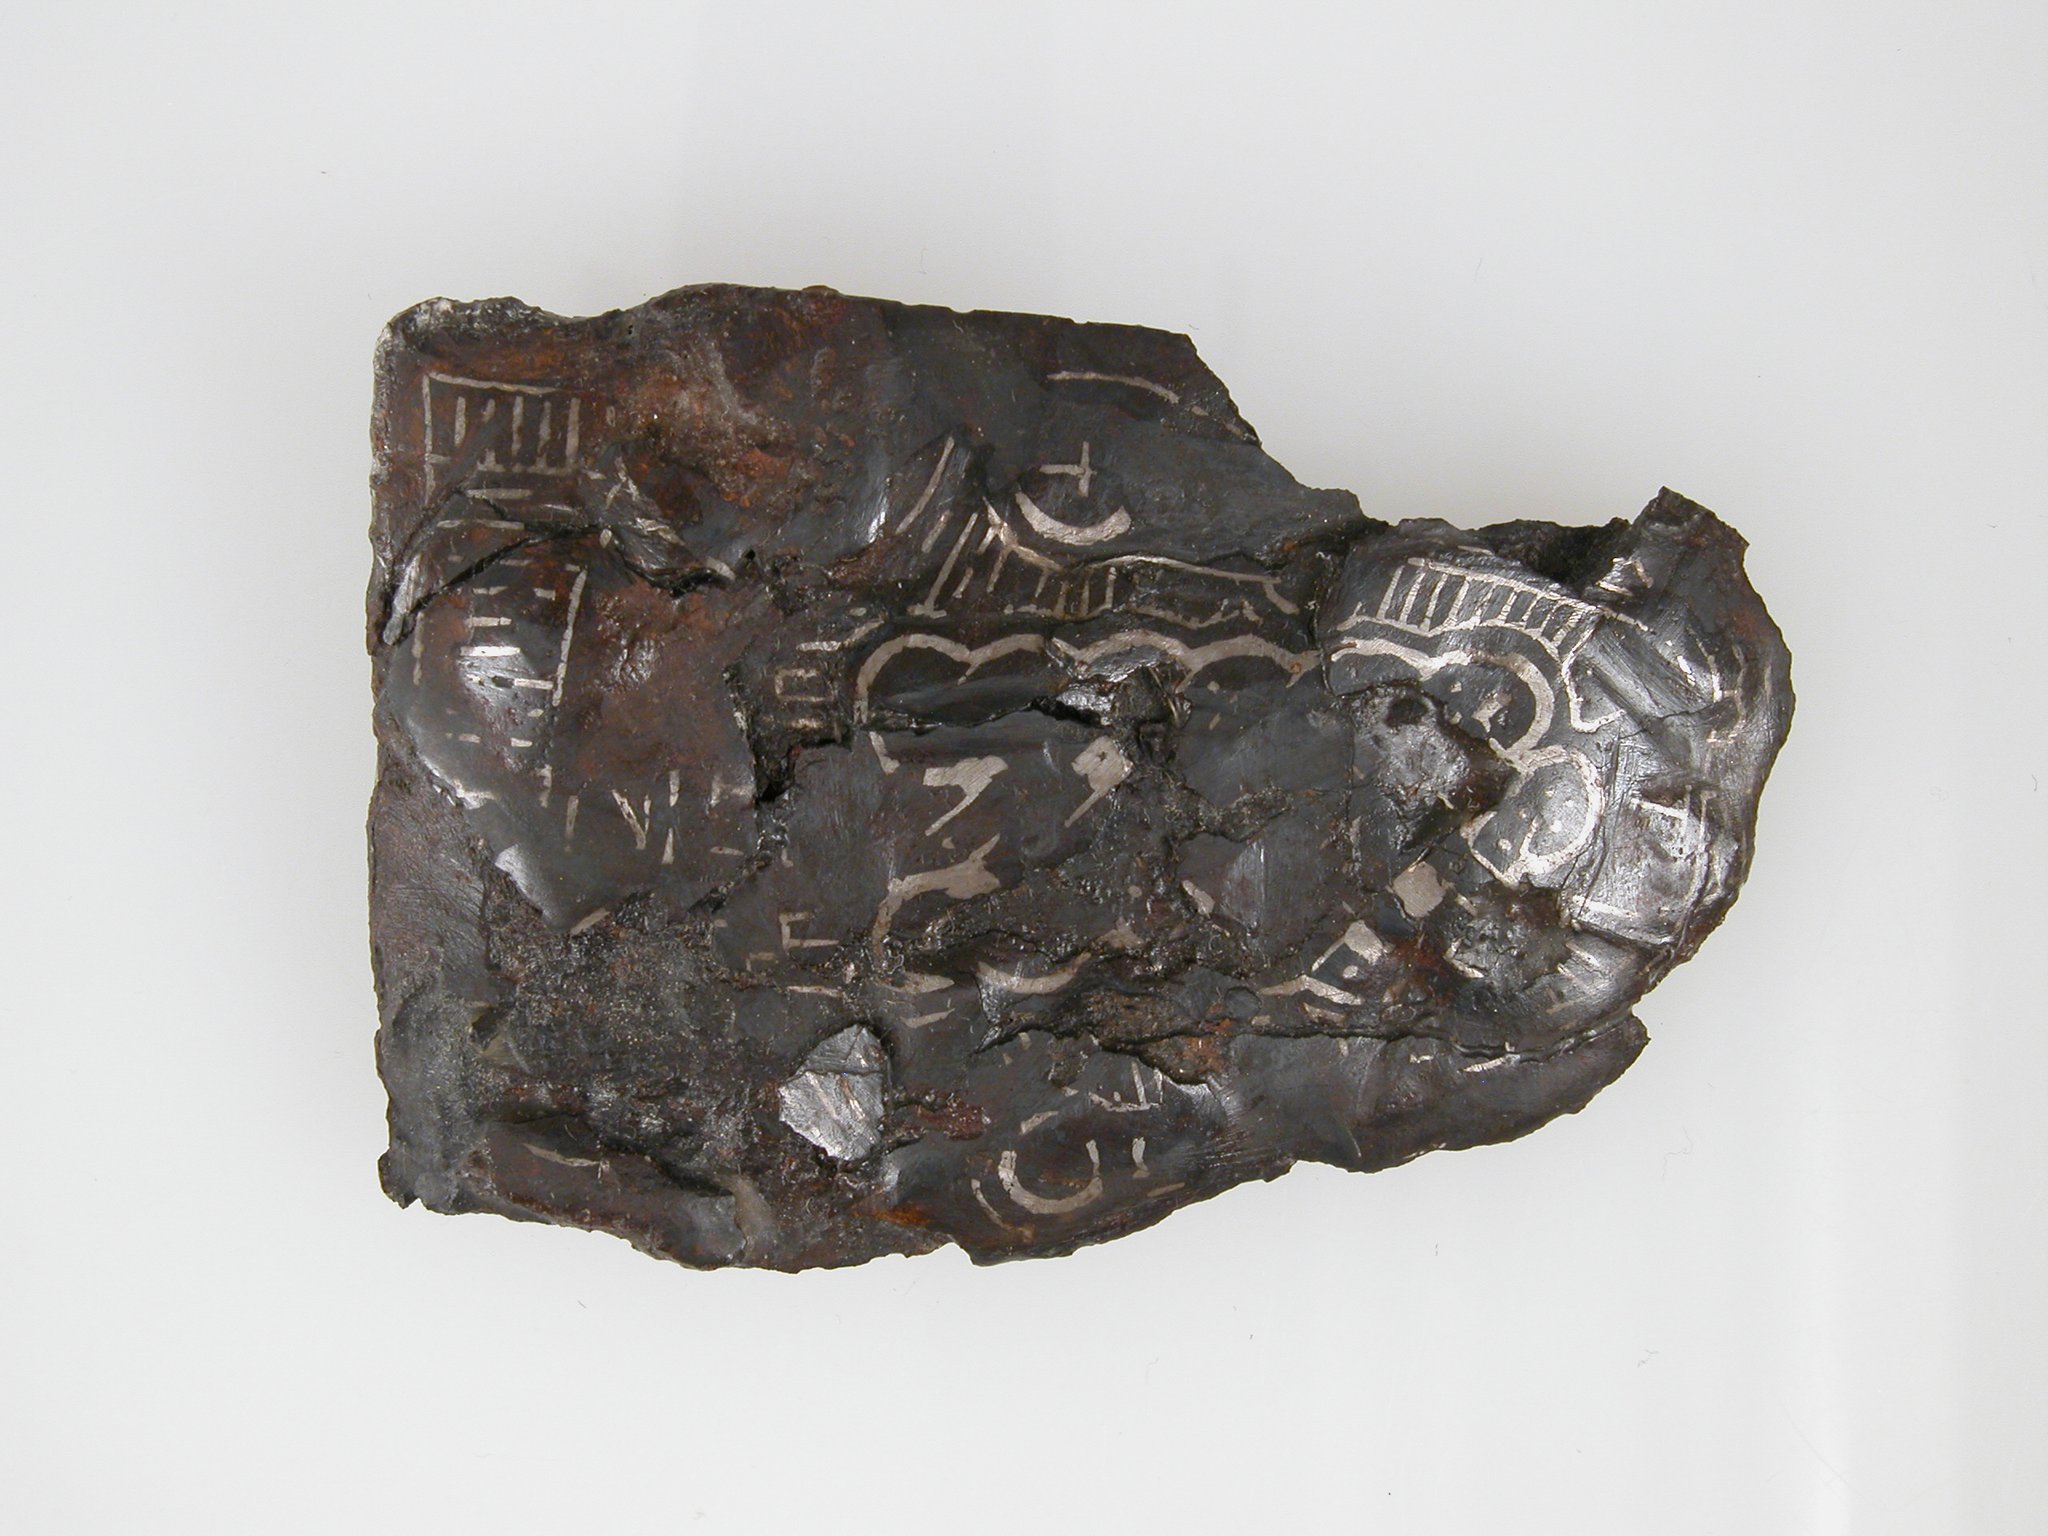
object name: belt plate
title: Counter Plate of a Belt Buckle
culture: frankish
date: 601-700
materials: iron, silver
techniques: inlay